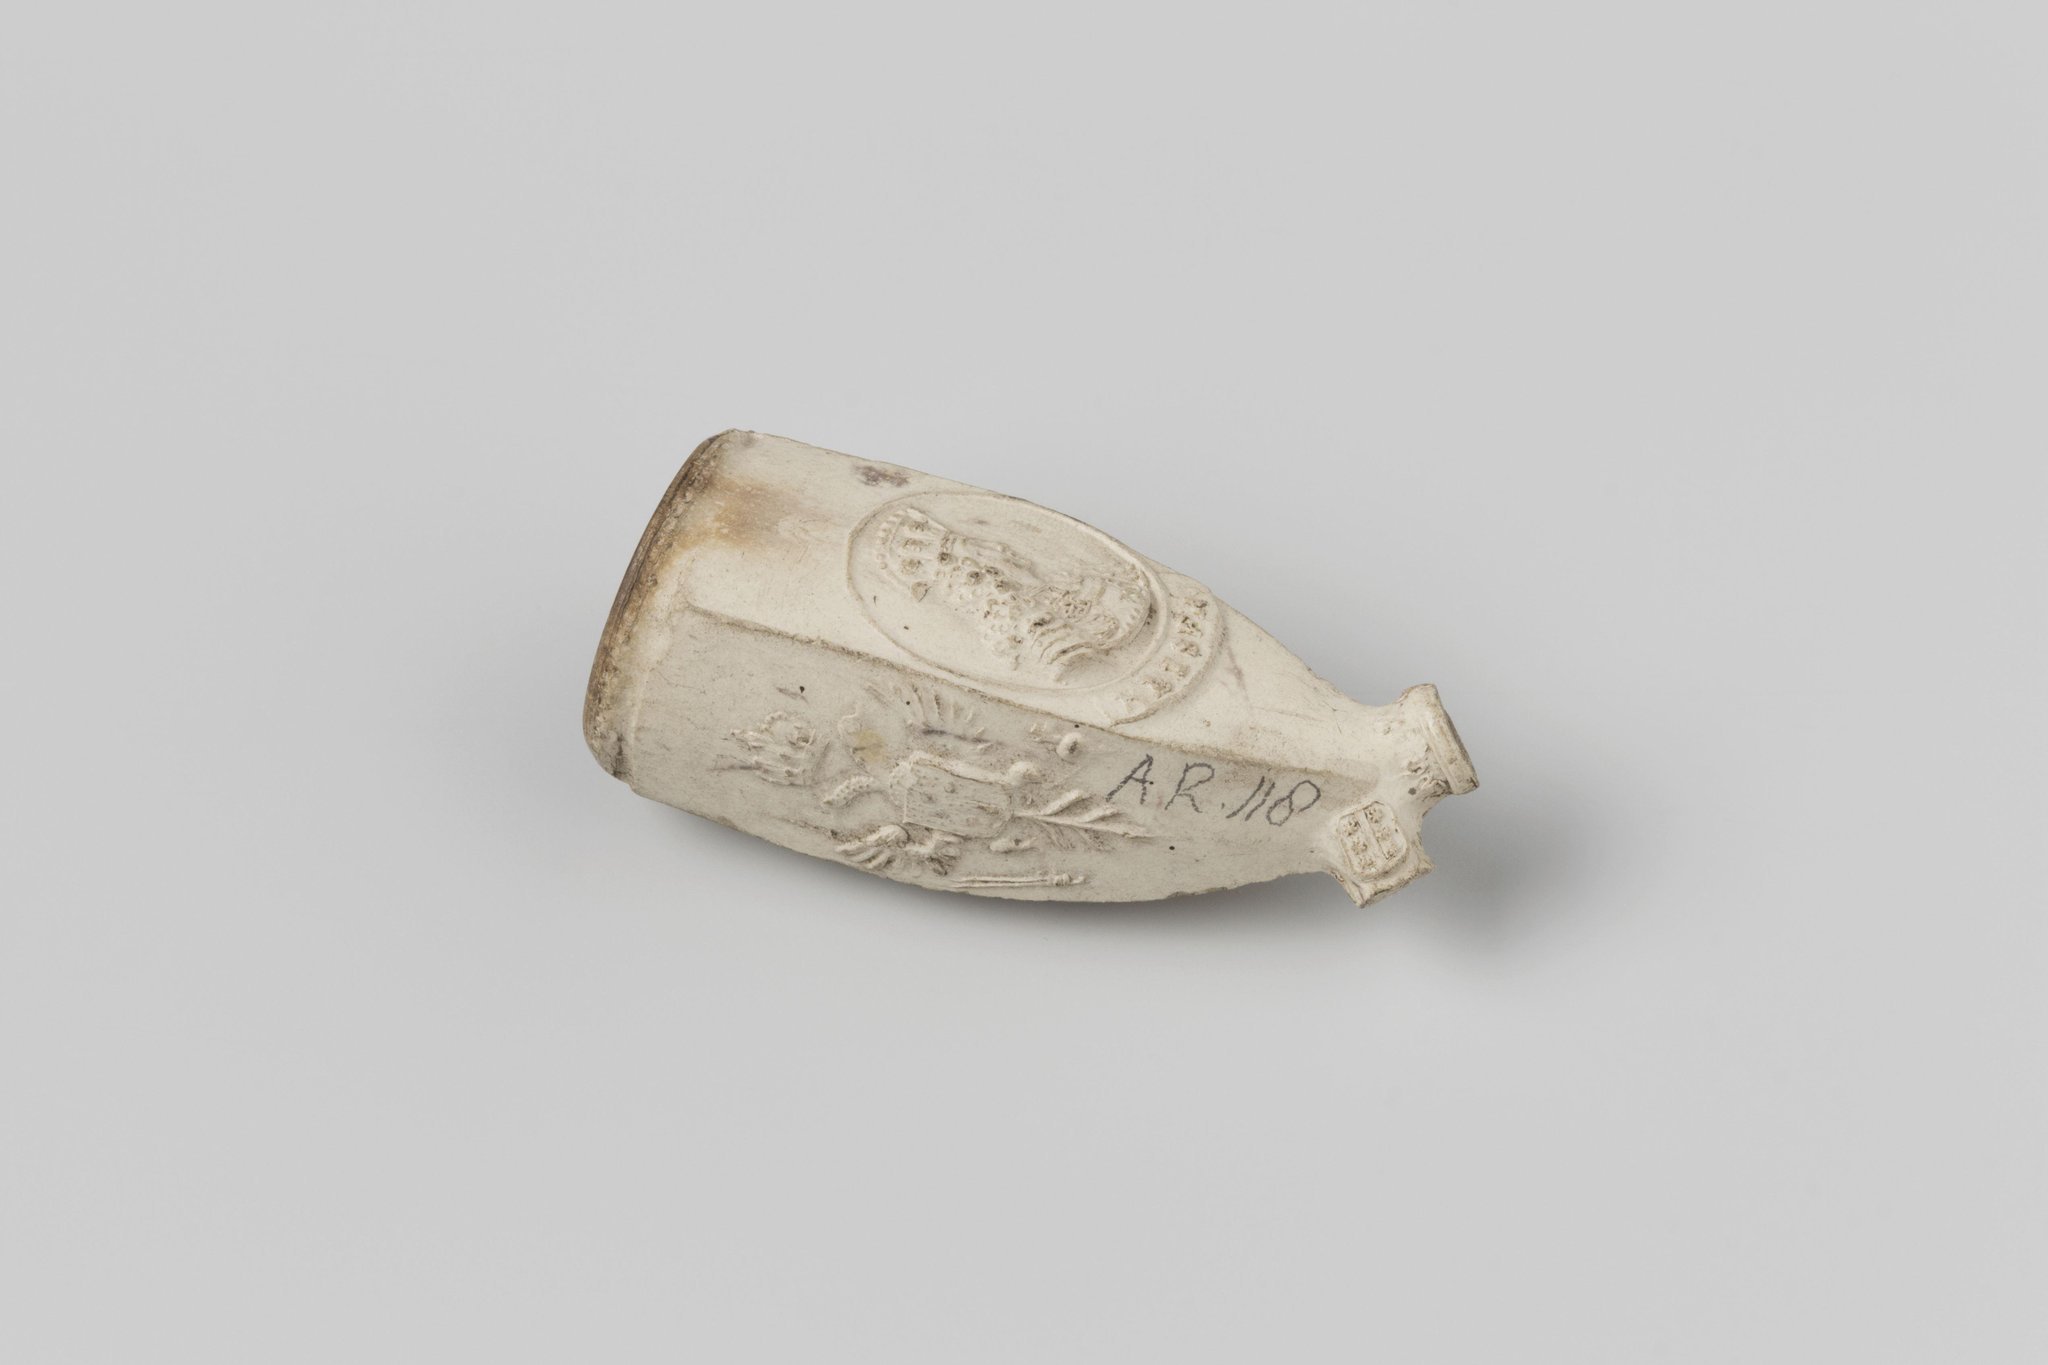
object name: fragment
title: Pijpenkop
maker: cornelis gruijtershof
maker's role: pijpenfabrikant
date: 1748-1770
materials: clay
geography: gouda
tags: vienna, maria theresia (rooms-duits keizerin), frans i stefan (duits keizer)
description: Pijpenkop met afgevlakte zijden met op twee zijden de portretten van koning-keizer Frans en keizerin Maria Theresia en het wapen van Hongarije. Van de opgravingen op de Hofstede Arentsburg 1827-1831 onder toezicht van Professor Reuvens.